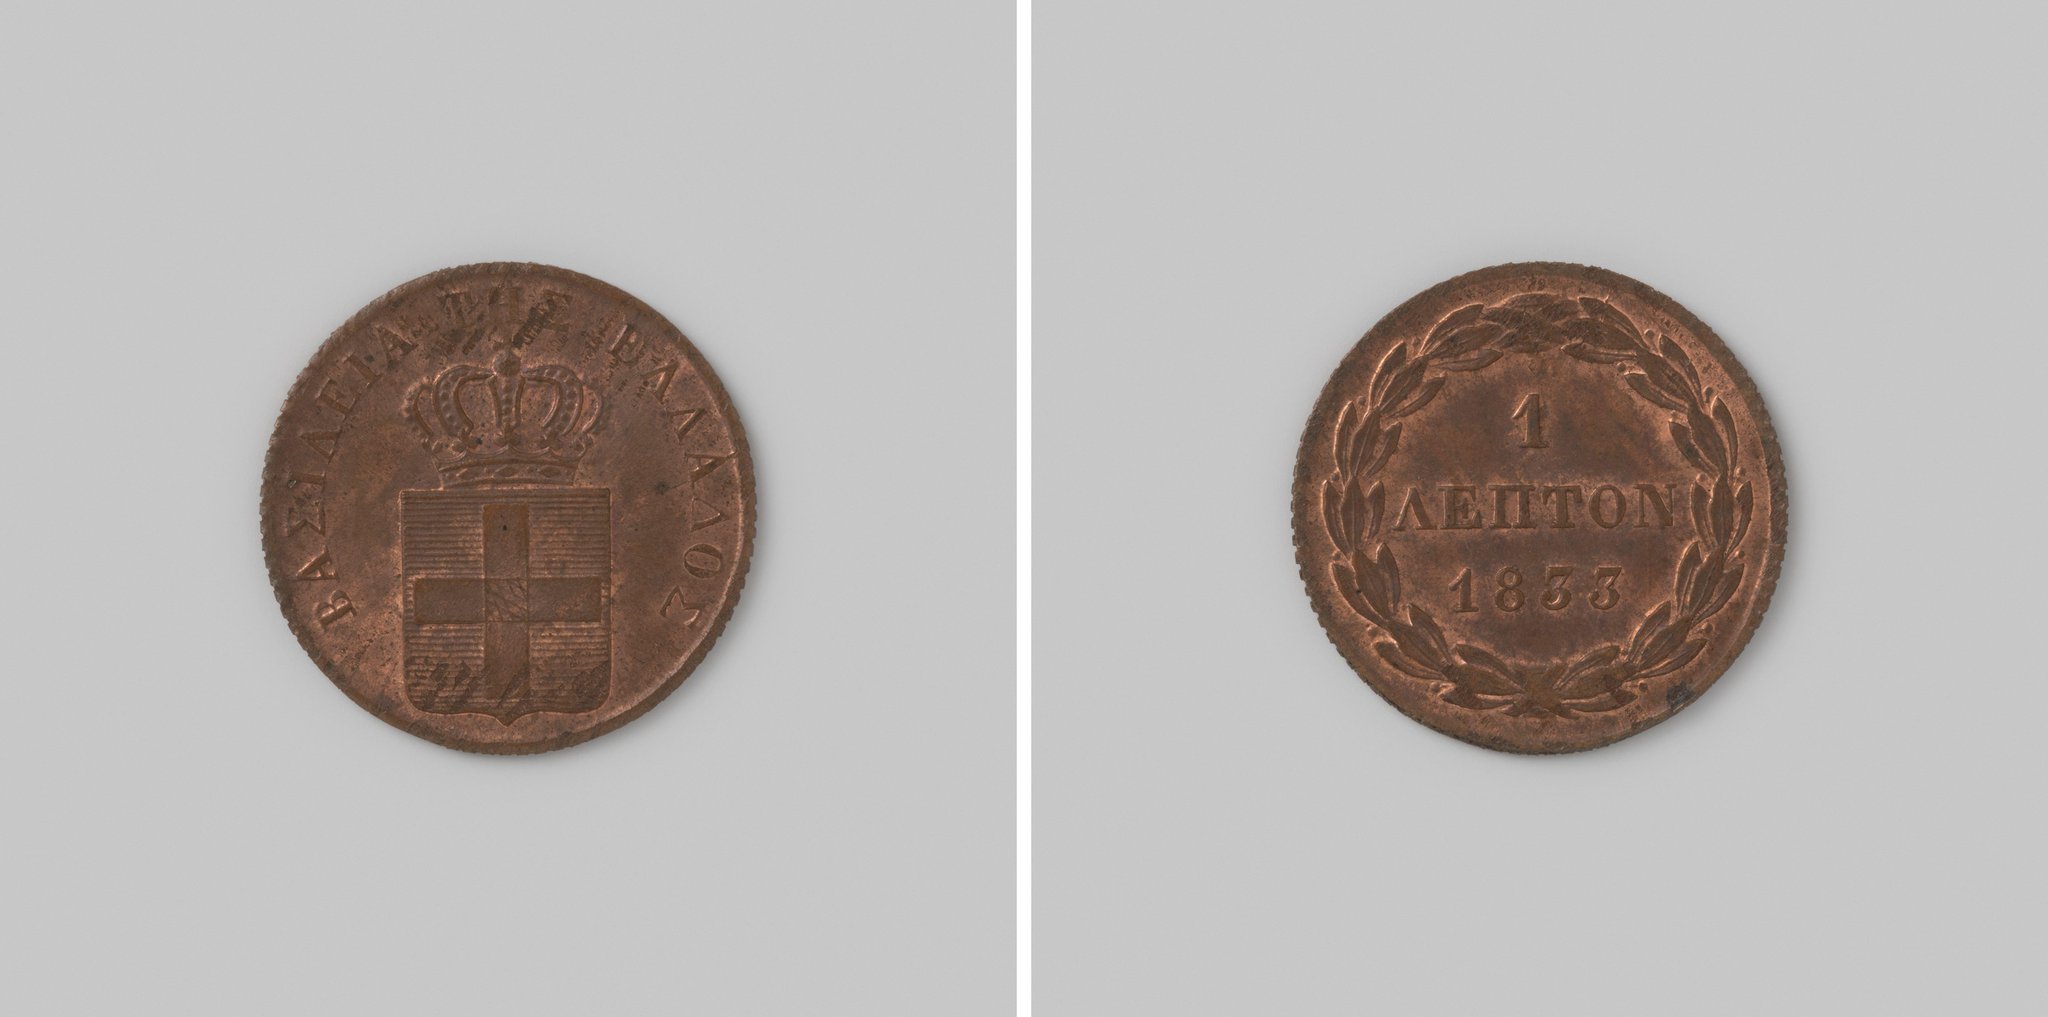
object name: coin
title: Lepton uit Griekenland van koning Otto I, 1833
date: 1833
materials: copper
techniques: striking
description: Koperen munt. Voorzijde: gekroond wapenschild. Keerzijde: binnen krans van bladeren waarde-aanduiding in twee regels, waaronder jaartal. Kartelrand.